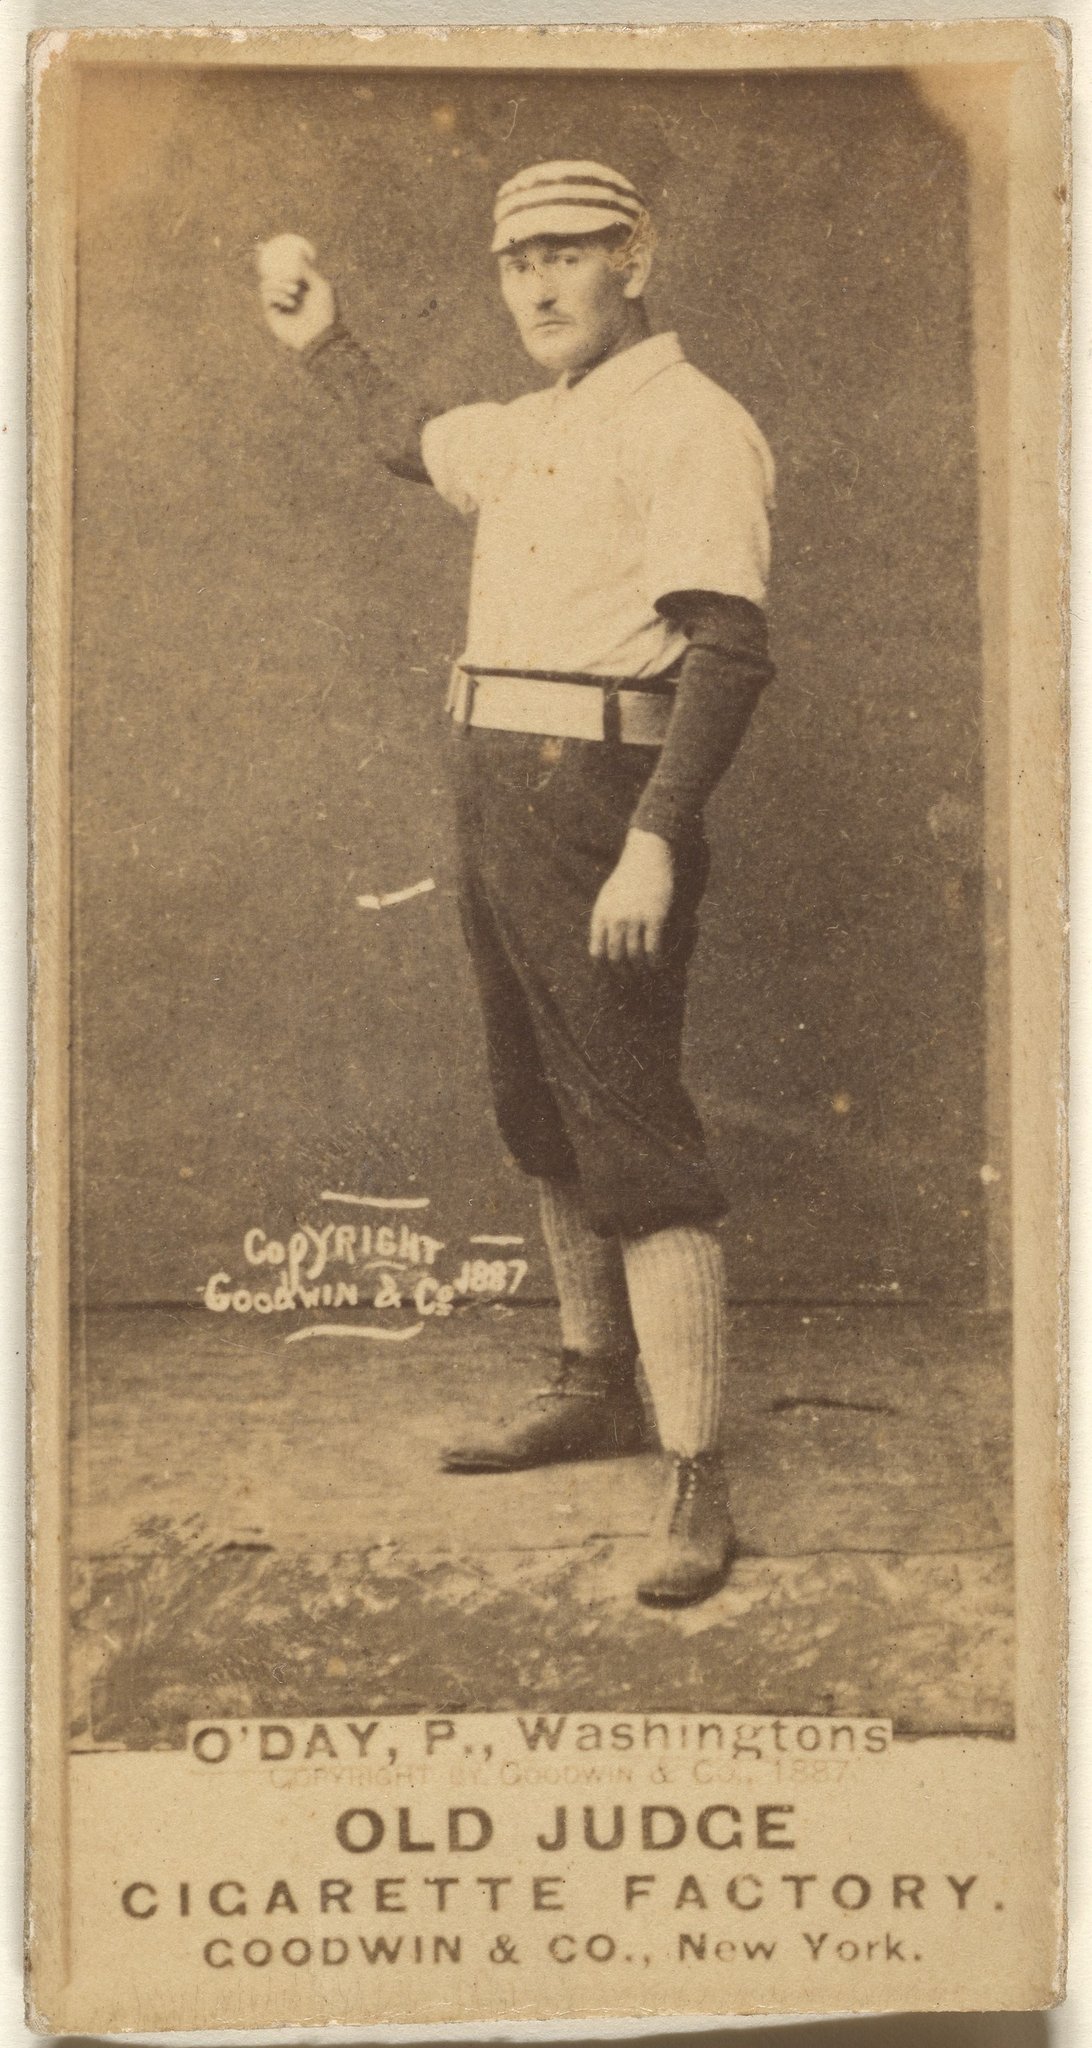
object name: baseball card, photograph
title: Henry Francis "Hank" O'Day, Pitcher, Washington Nationals, from the Old Judge series (N172) for Old Judge Cigarettes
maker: goodwin & company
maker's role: publisher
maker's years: 1850-1950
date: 1887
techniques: albumen silver print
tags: men,portraits,baseball,athletes